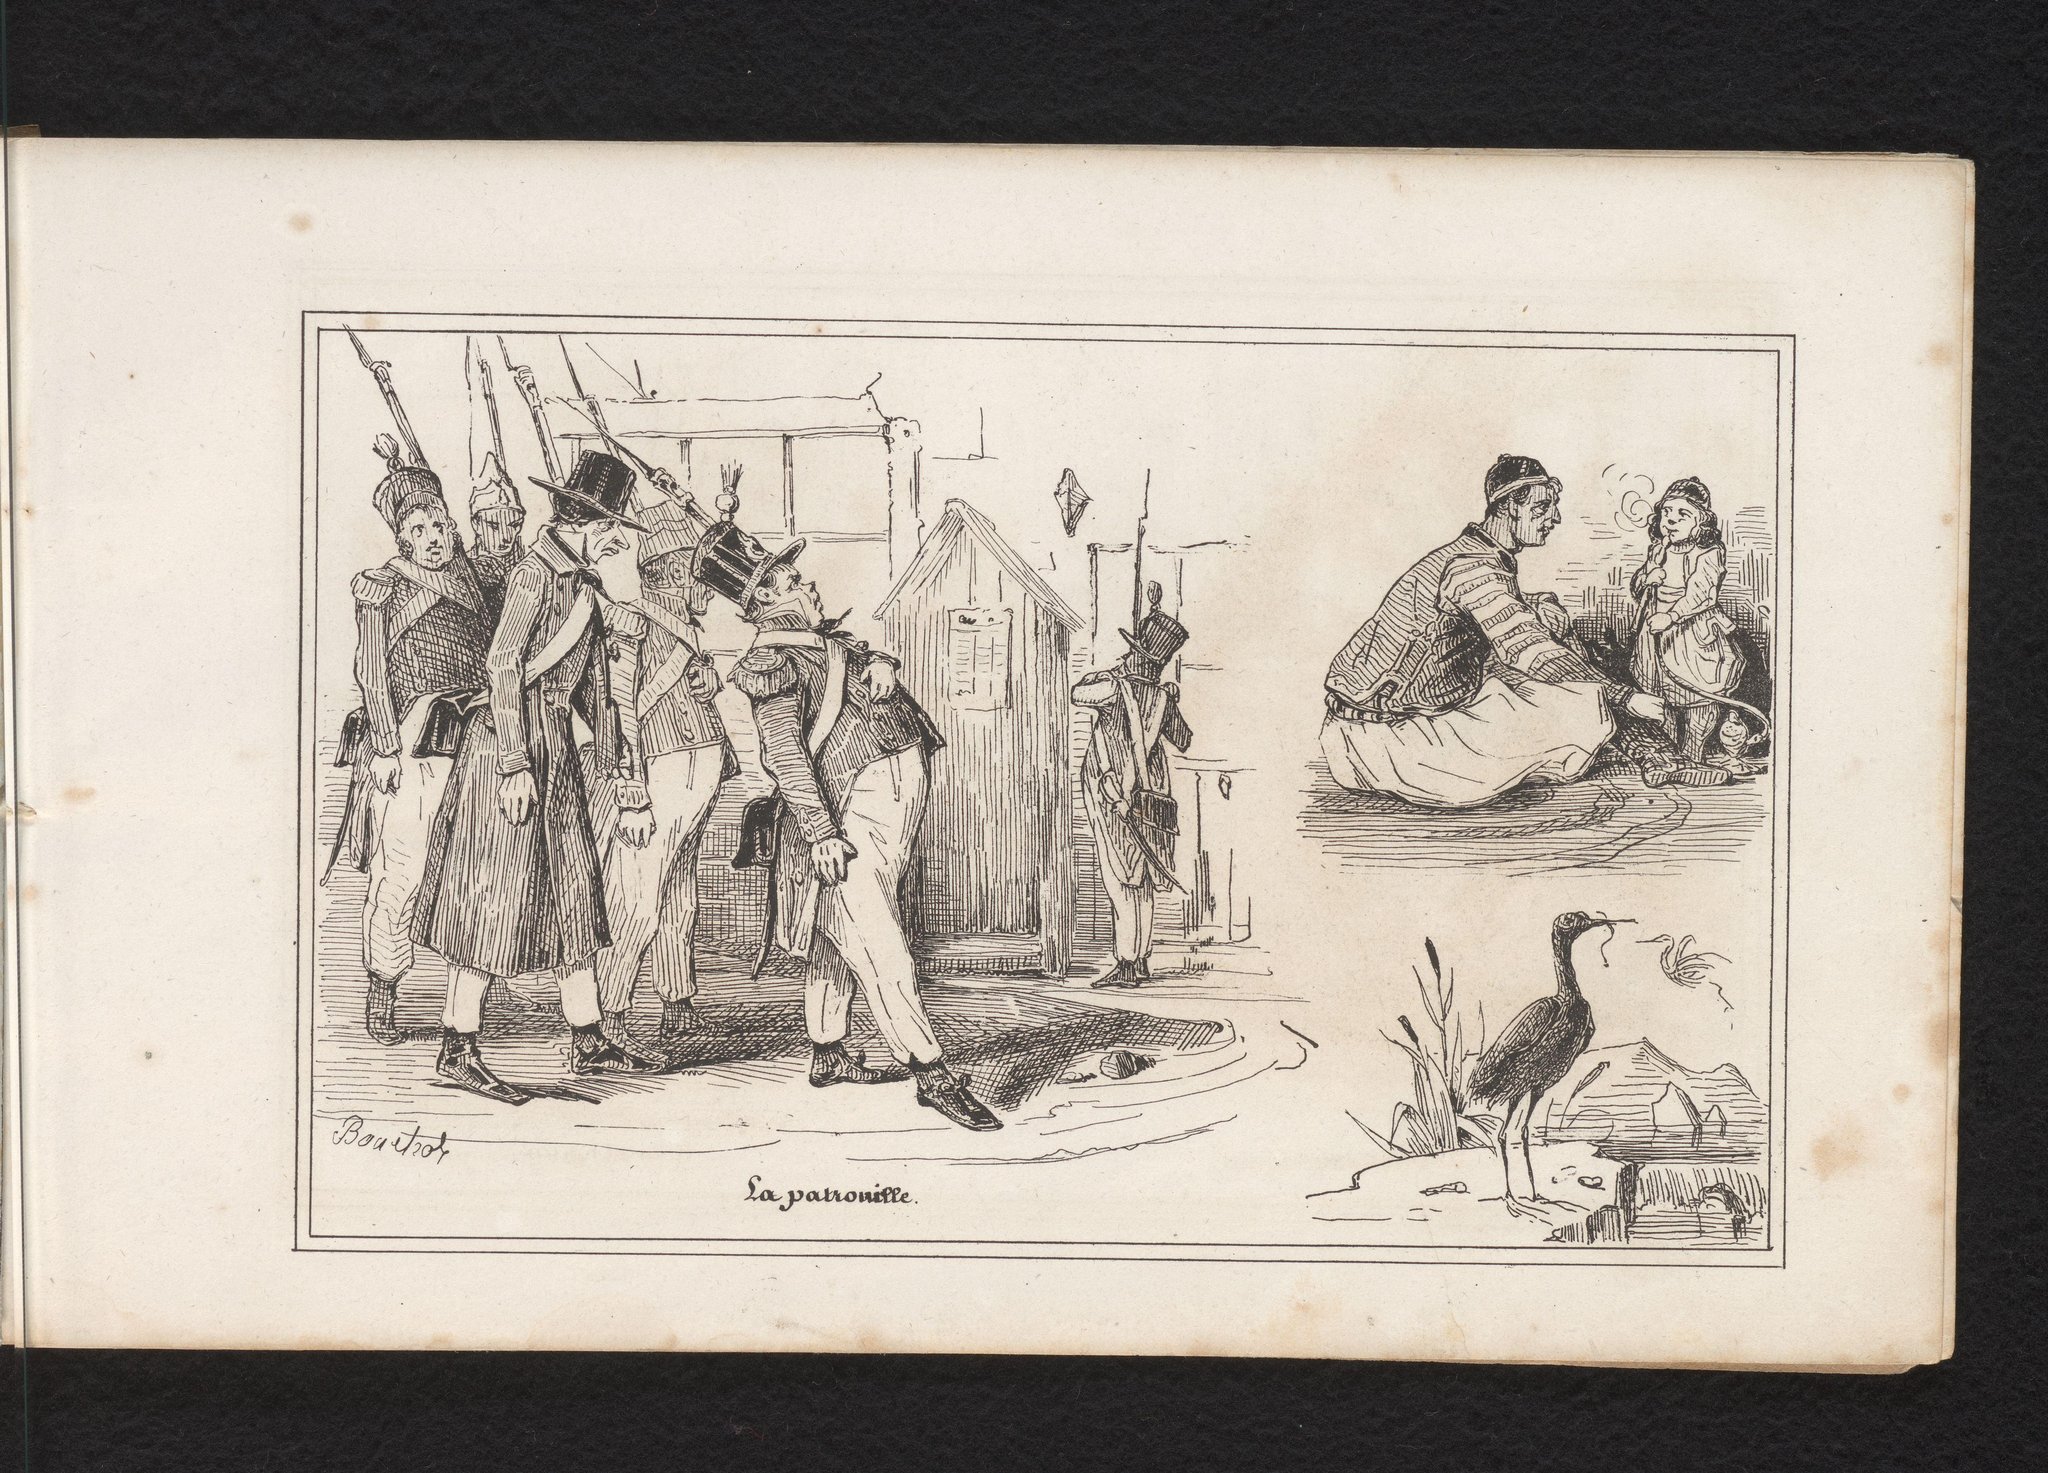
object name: print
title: Kleine verzameling van prenten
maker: frédéric bouchot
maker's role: draughtsman, print maker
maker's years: 1798-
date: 1834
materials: paper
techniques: engraving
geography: paris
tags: water-pipe, hookah, narghile, shore-birds and wading-birds: stork, the soldier; the soldier's life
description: Blad met drie afzonderlijke voorstellingen. Deze prent maakt deel uit van een album.